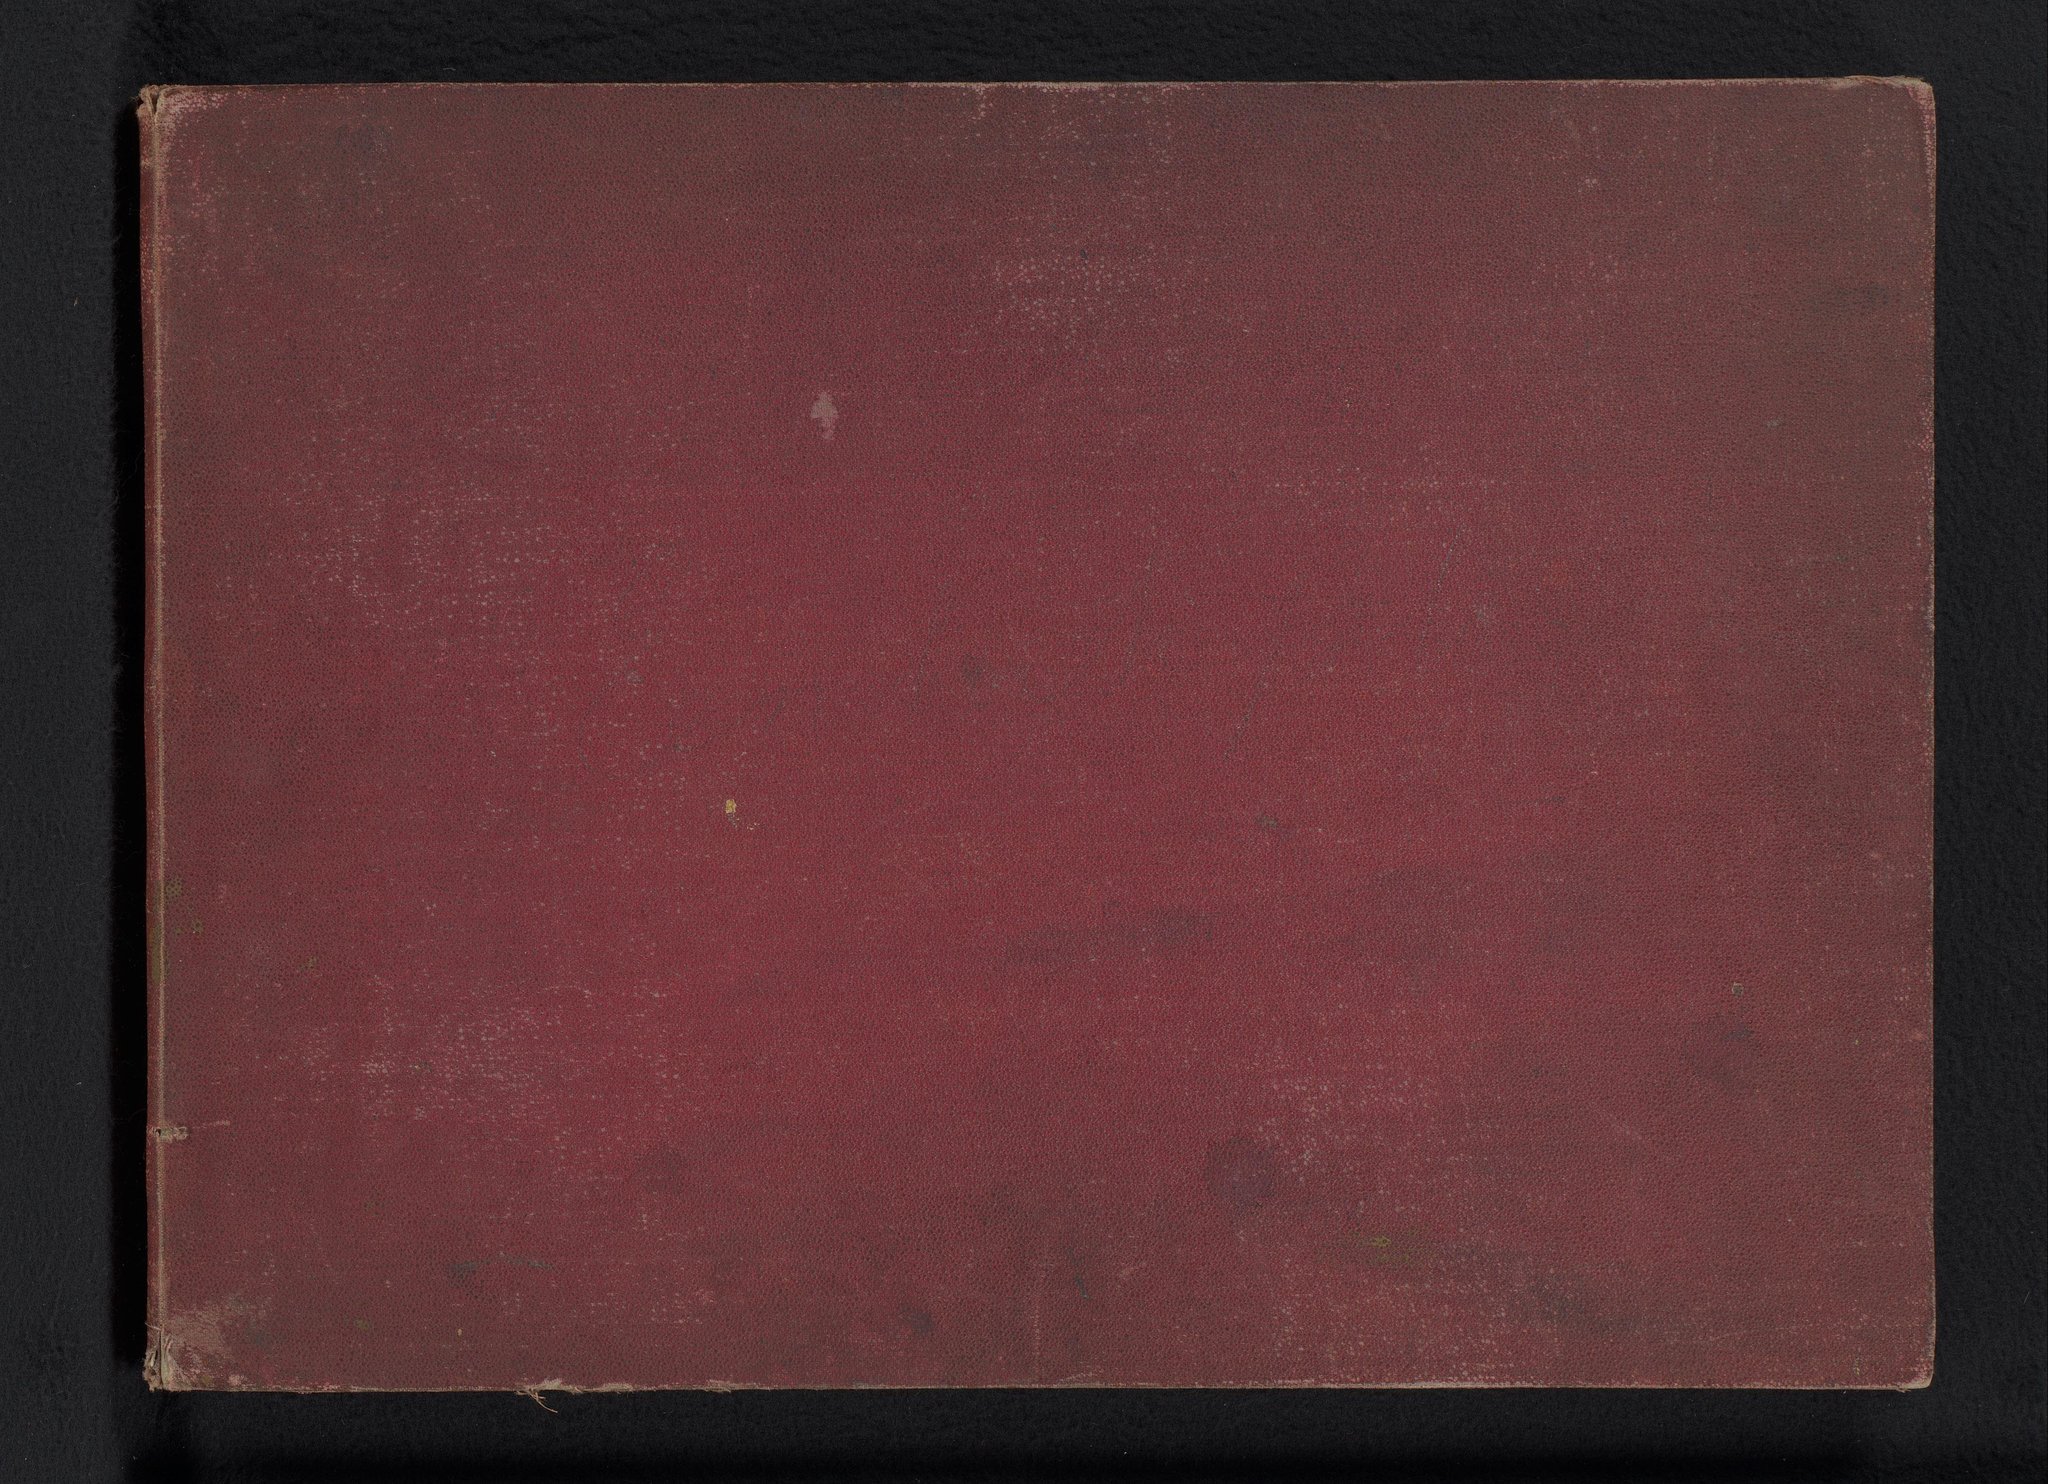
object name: photograph album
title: Fotoalbum met 36 foto's van het Alhambra in Spanje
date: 1906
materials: cardboard, leather, paper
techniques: albumen print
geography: granada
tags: towers ~ fortified city, stuccoeing, exterior ~ representation of a building, interior ~ representation of a building, inner court of palace or 'hôtel'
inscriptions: number: ‘165’, inscription: ‘900€ BR 2616’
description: Fotoalbum met in totaal 36 pagina's waarop 36 albuminedrukken geplakt zijn. Afgebeeld zijn interieur- en exterieurfoto's van het Alhambra te Granada, Spanje. De foto's in het album zijn toegeschreven aan C. (Carlos, Charles) Maufsaise.